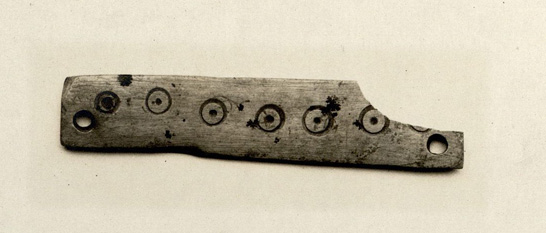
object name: inlay from toilet box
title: Inlay from box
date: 1981-1640 BCE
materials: bone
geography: egypt